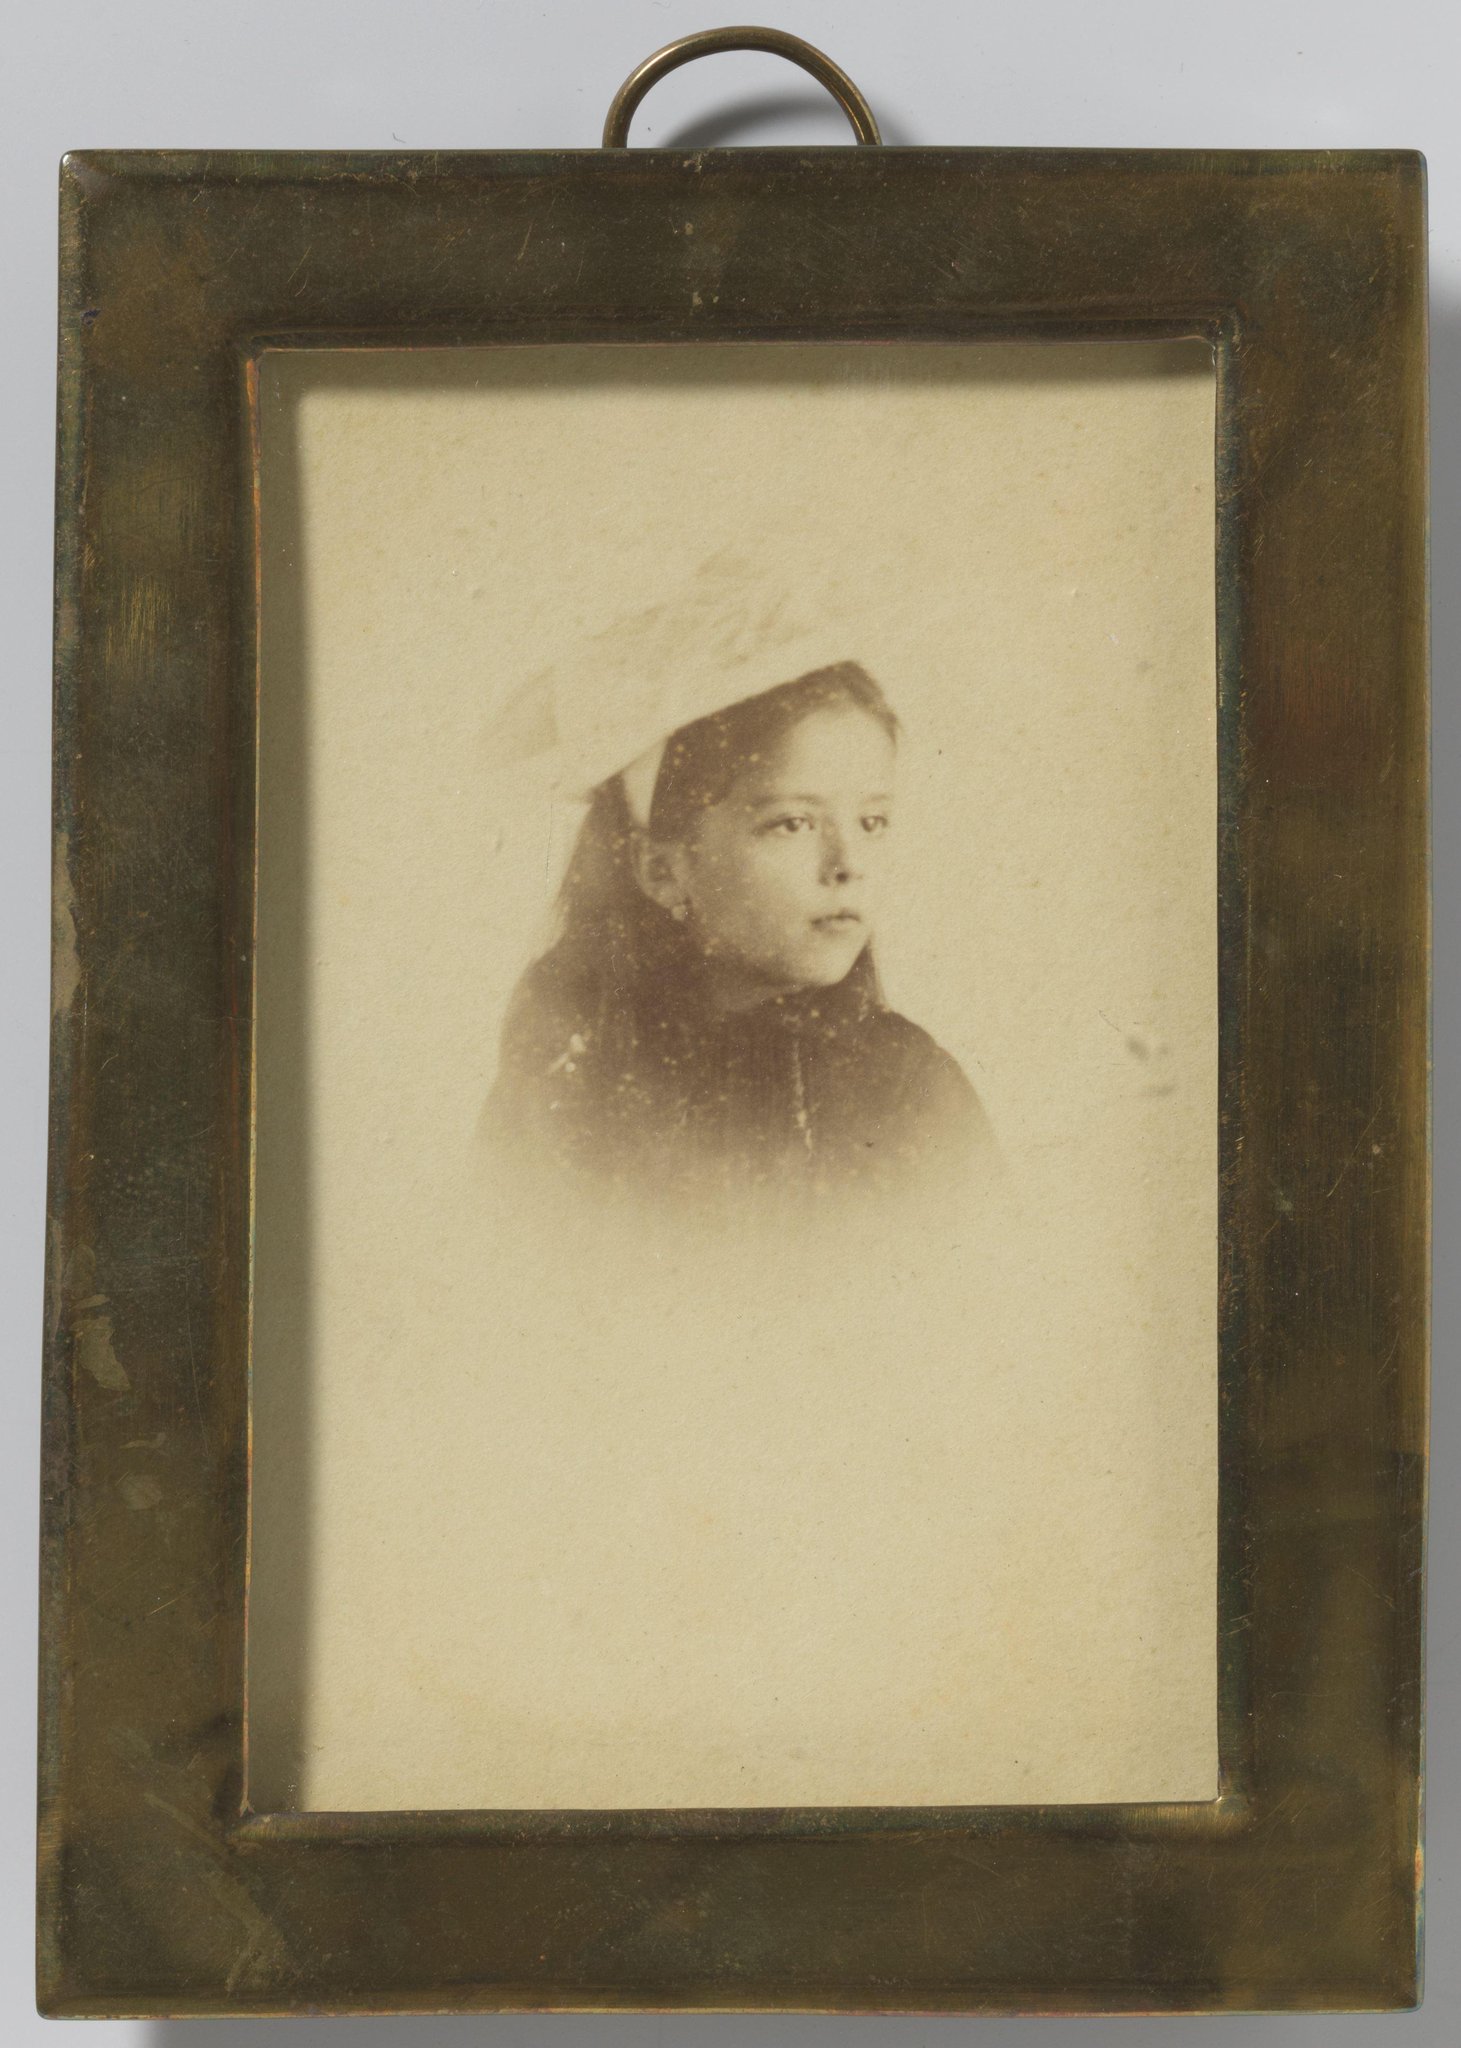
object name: frame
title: Portret van een onbekend meisje met hoed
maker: Anonymous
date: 1880-1900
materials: cardboard, glass, metal, paper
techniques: albumen print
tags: girl (child between toddler and youth), anonymous historical person portrayed